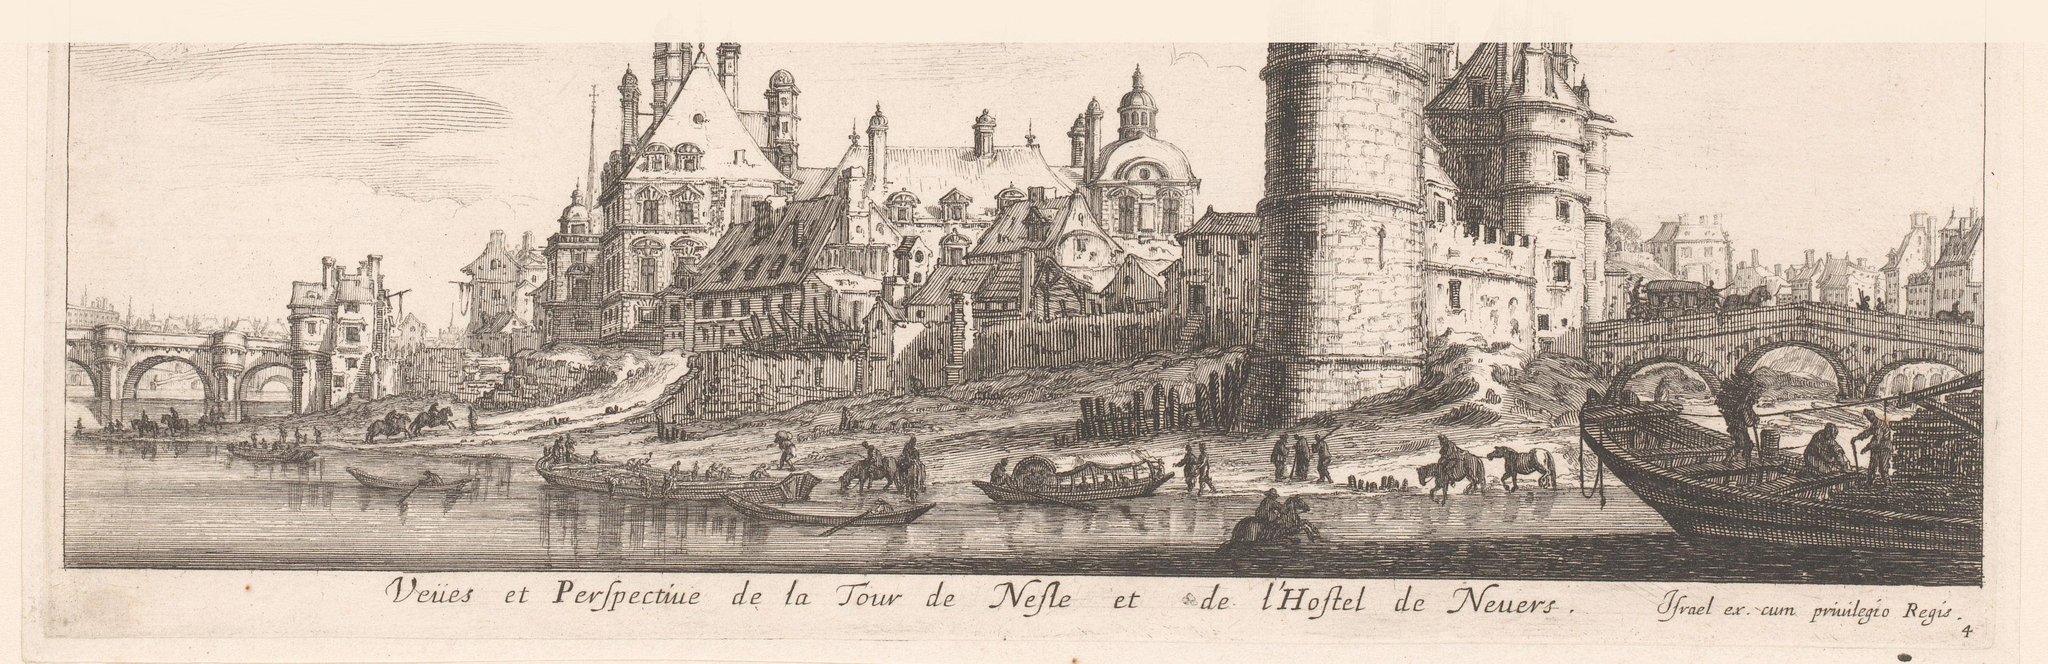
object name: print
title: Vues de Paris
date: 1630-1661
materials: paper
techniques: engraving, etching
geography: france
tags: city-view in general; 'veduta', hôtel, i.e. small palace in city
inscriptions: collector's mark: Lugt 240